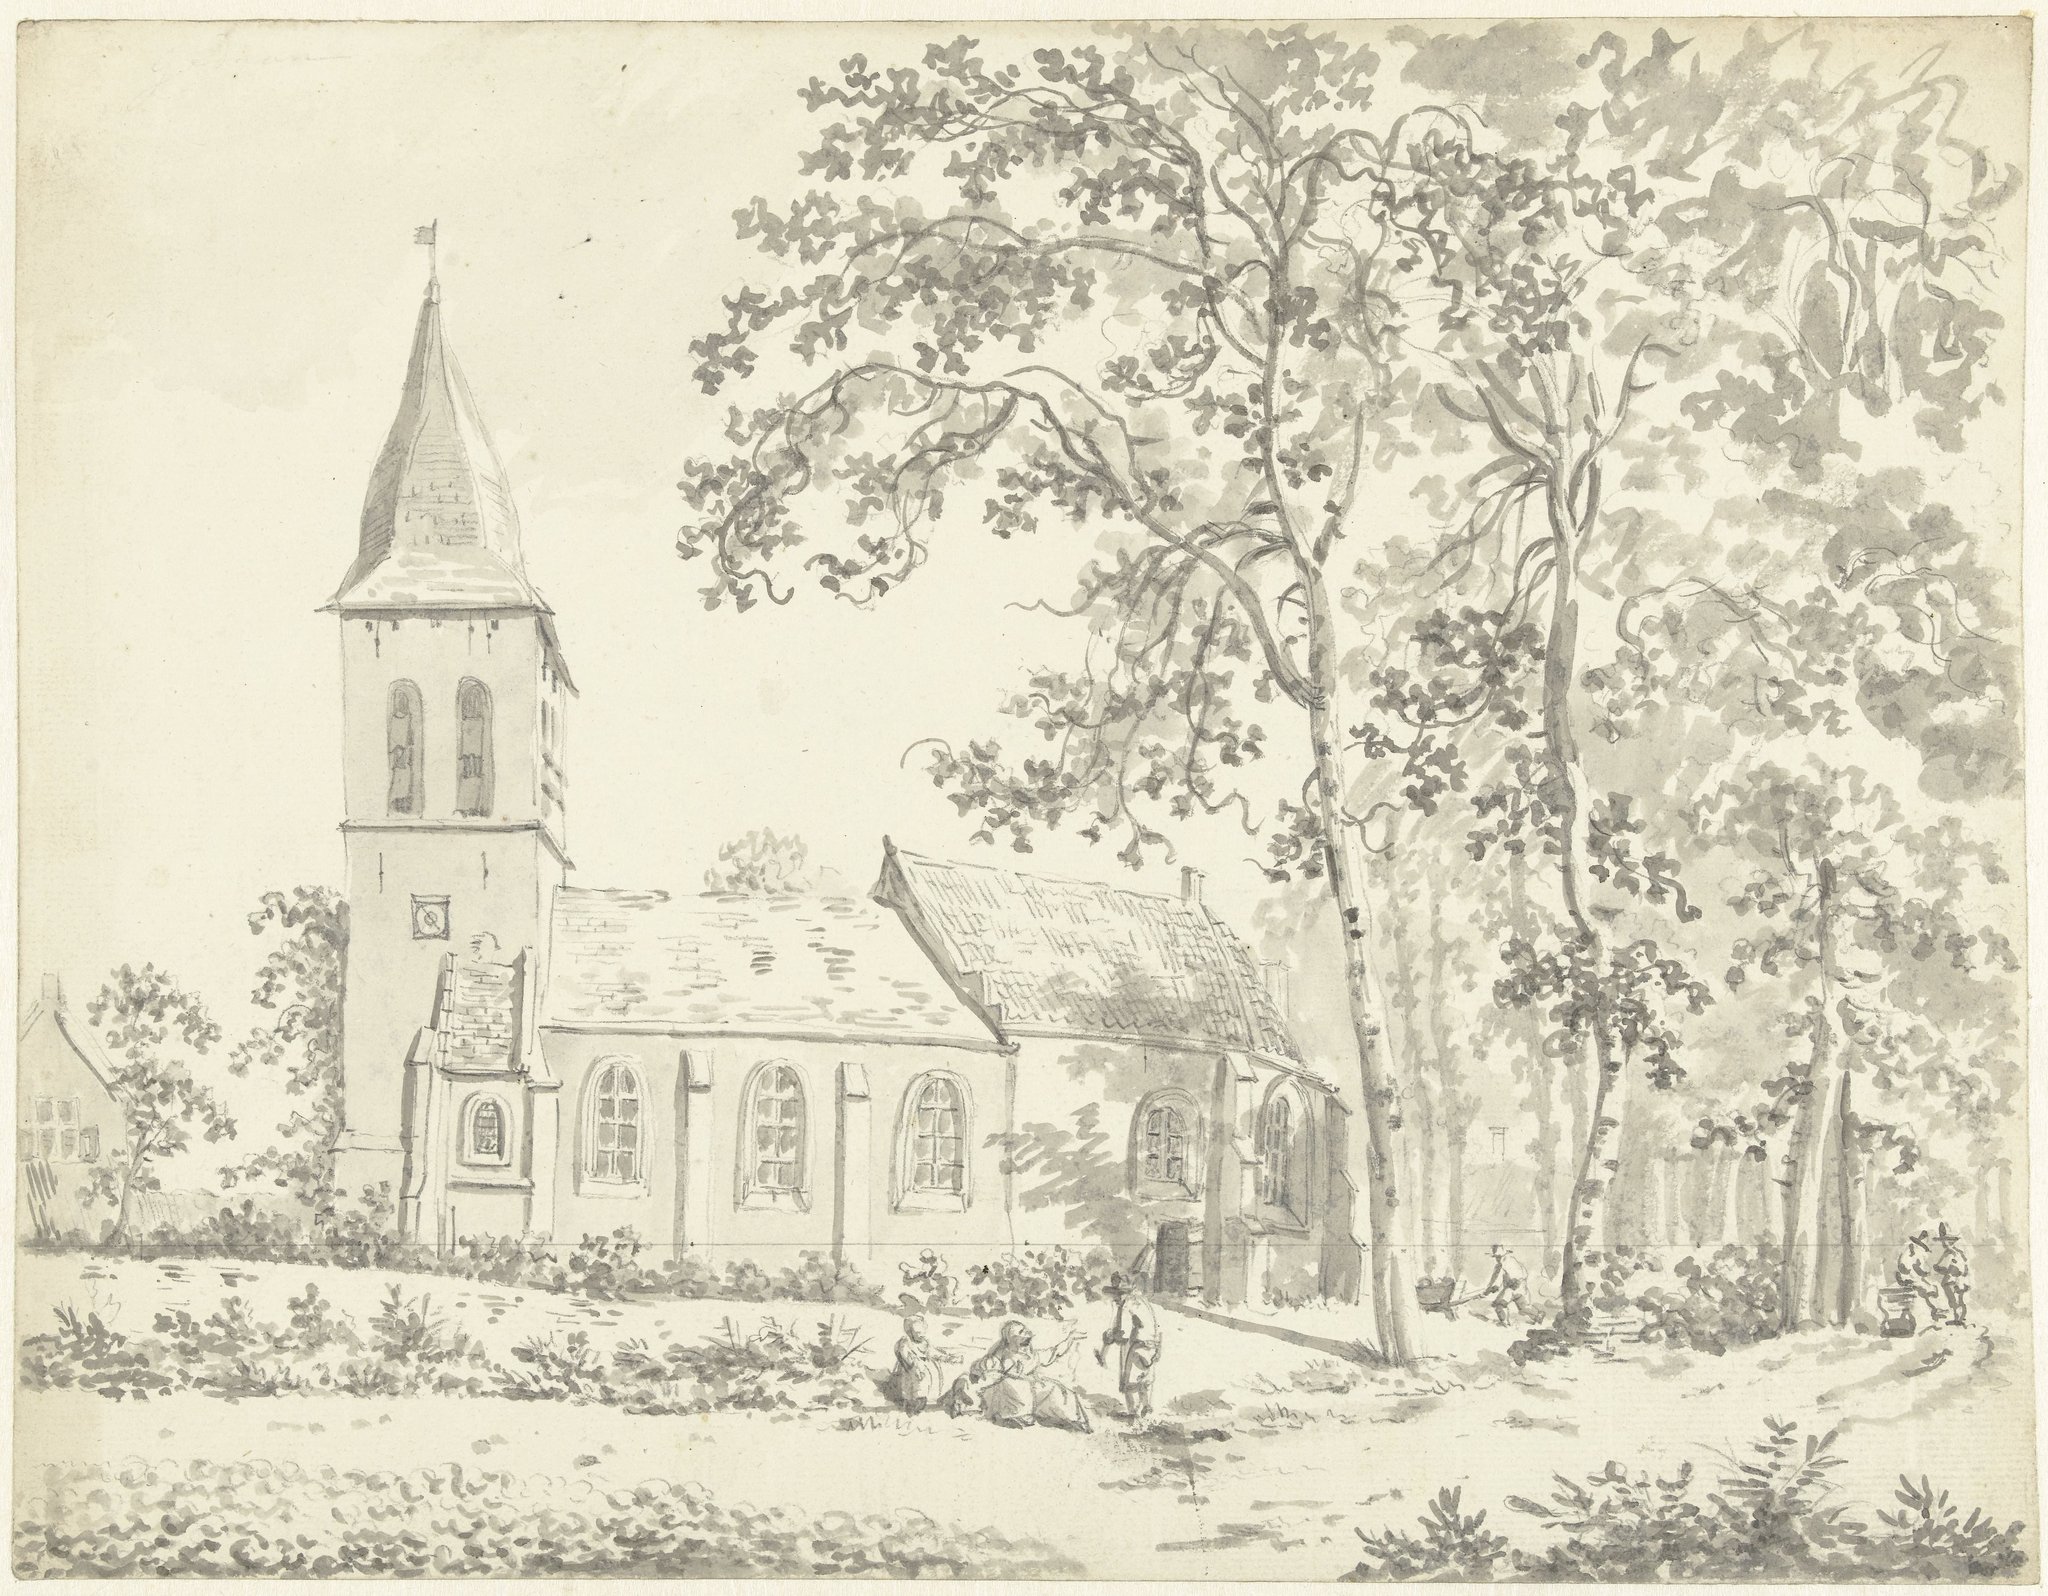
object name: drawing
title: De kerk te Schore, op Zuid-Beveland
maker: Anonymous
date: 1700-1800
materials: paper, pencil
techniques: brush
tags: church (exterior)